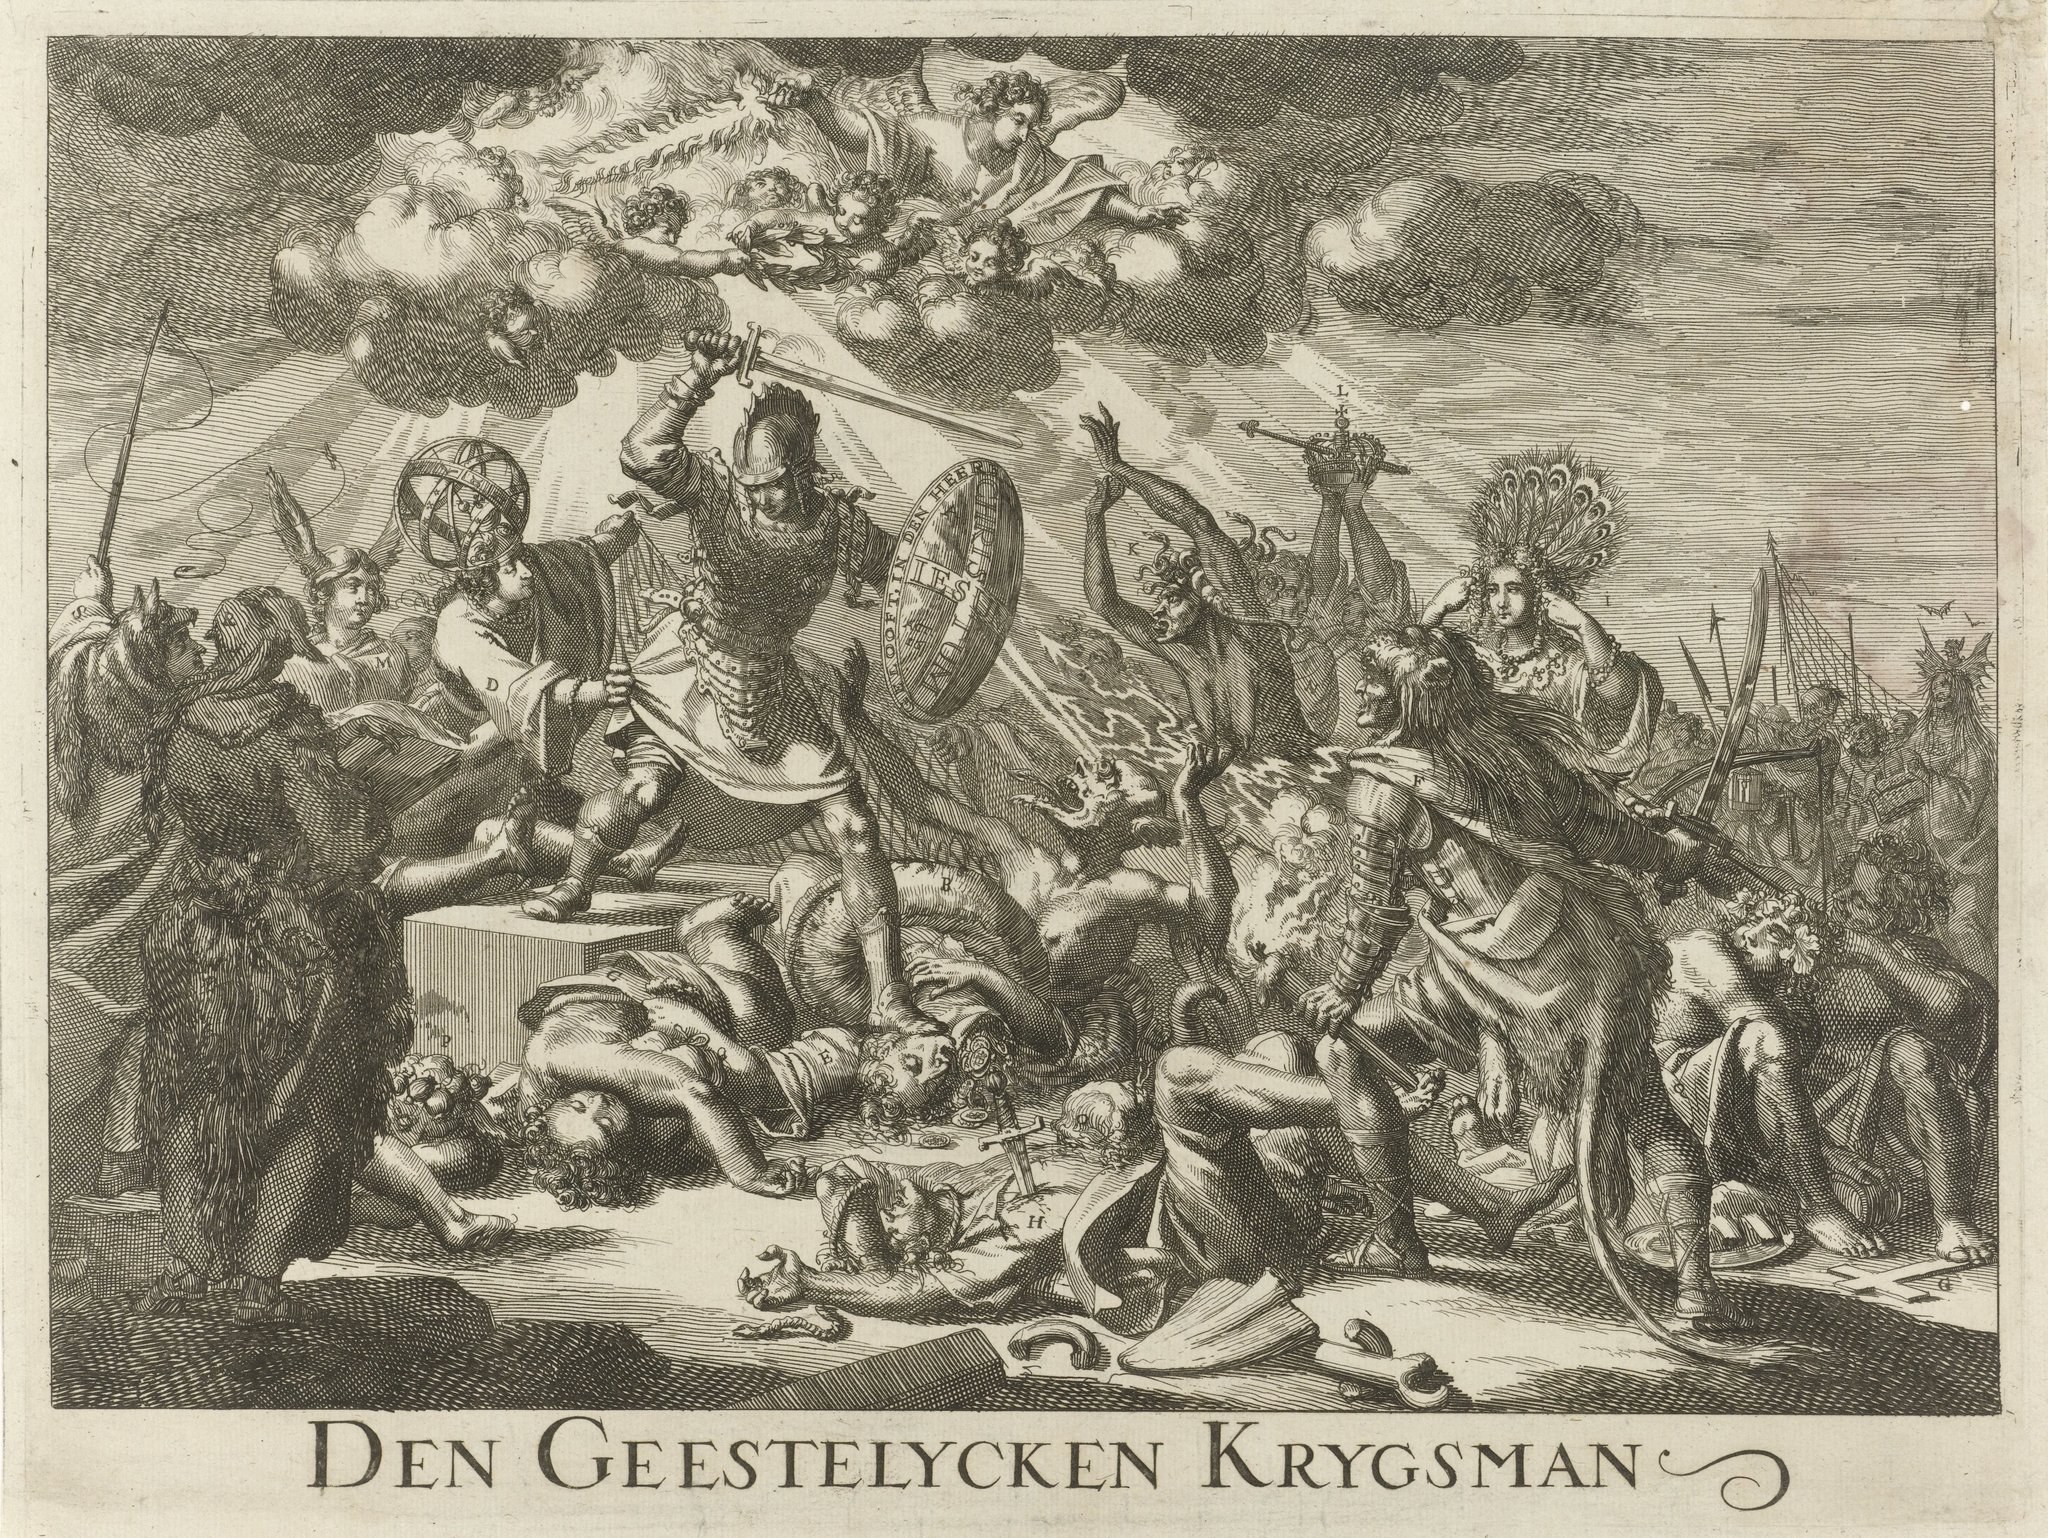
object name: print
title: Den Geestelycken Krygsman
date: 1689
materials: paper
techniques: etching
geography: amsterdam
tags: the christian knight, 'miles christianus'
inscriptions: collector's mark: Lugt 2228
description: Allegorie waarin de Christelijke Ridder gewapend met zwaard en schild strijdt tegen de zonden en ondeugden als: Vlees, Wereld, Ongeloof, Wanhoop, Hoogmoed, Nijd, Onkuise Liefde en Gramschap. In de hemel een engel met een vlammend zwaard en putti die een lauwerkrans boven het hoofd van de ridder houden.